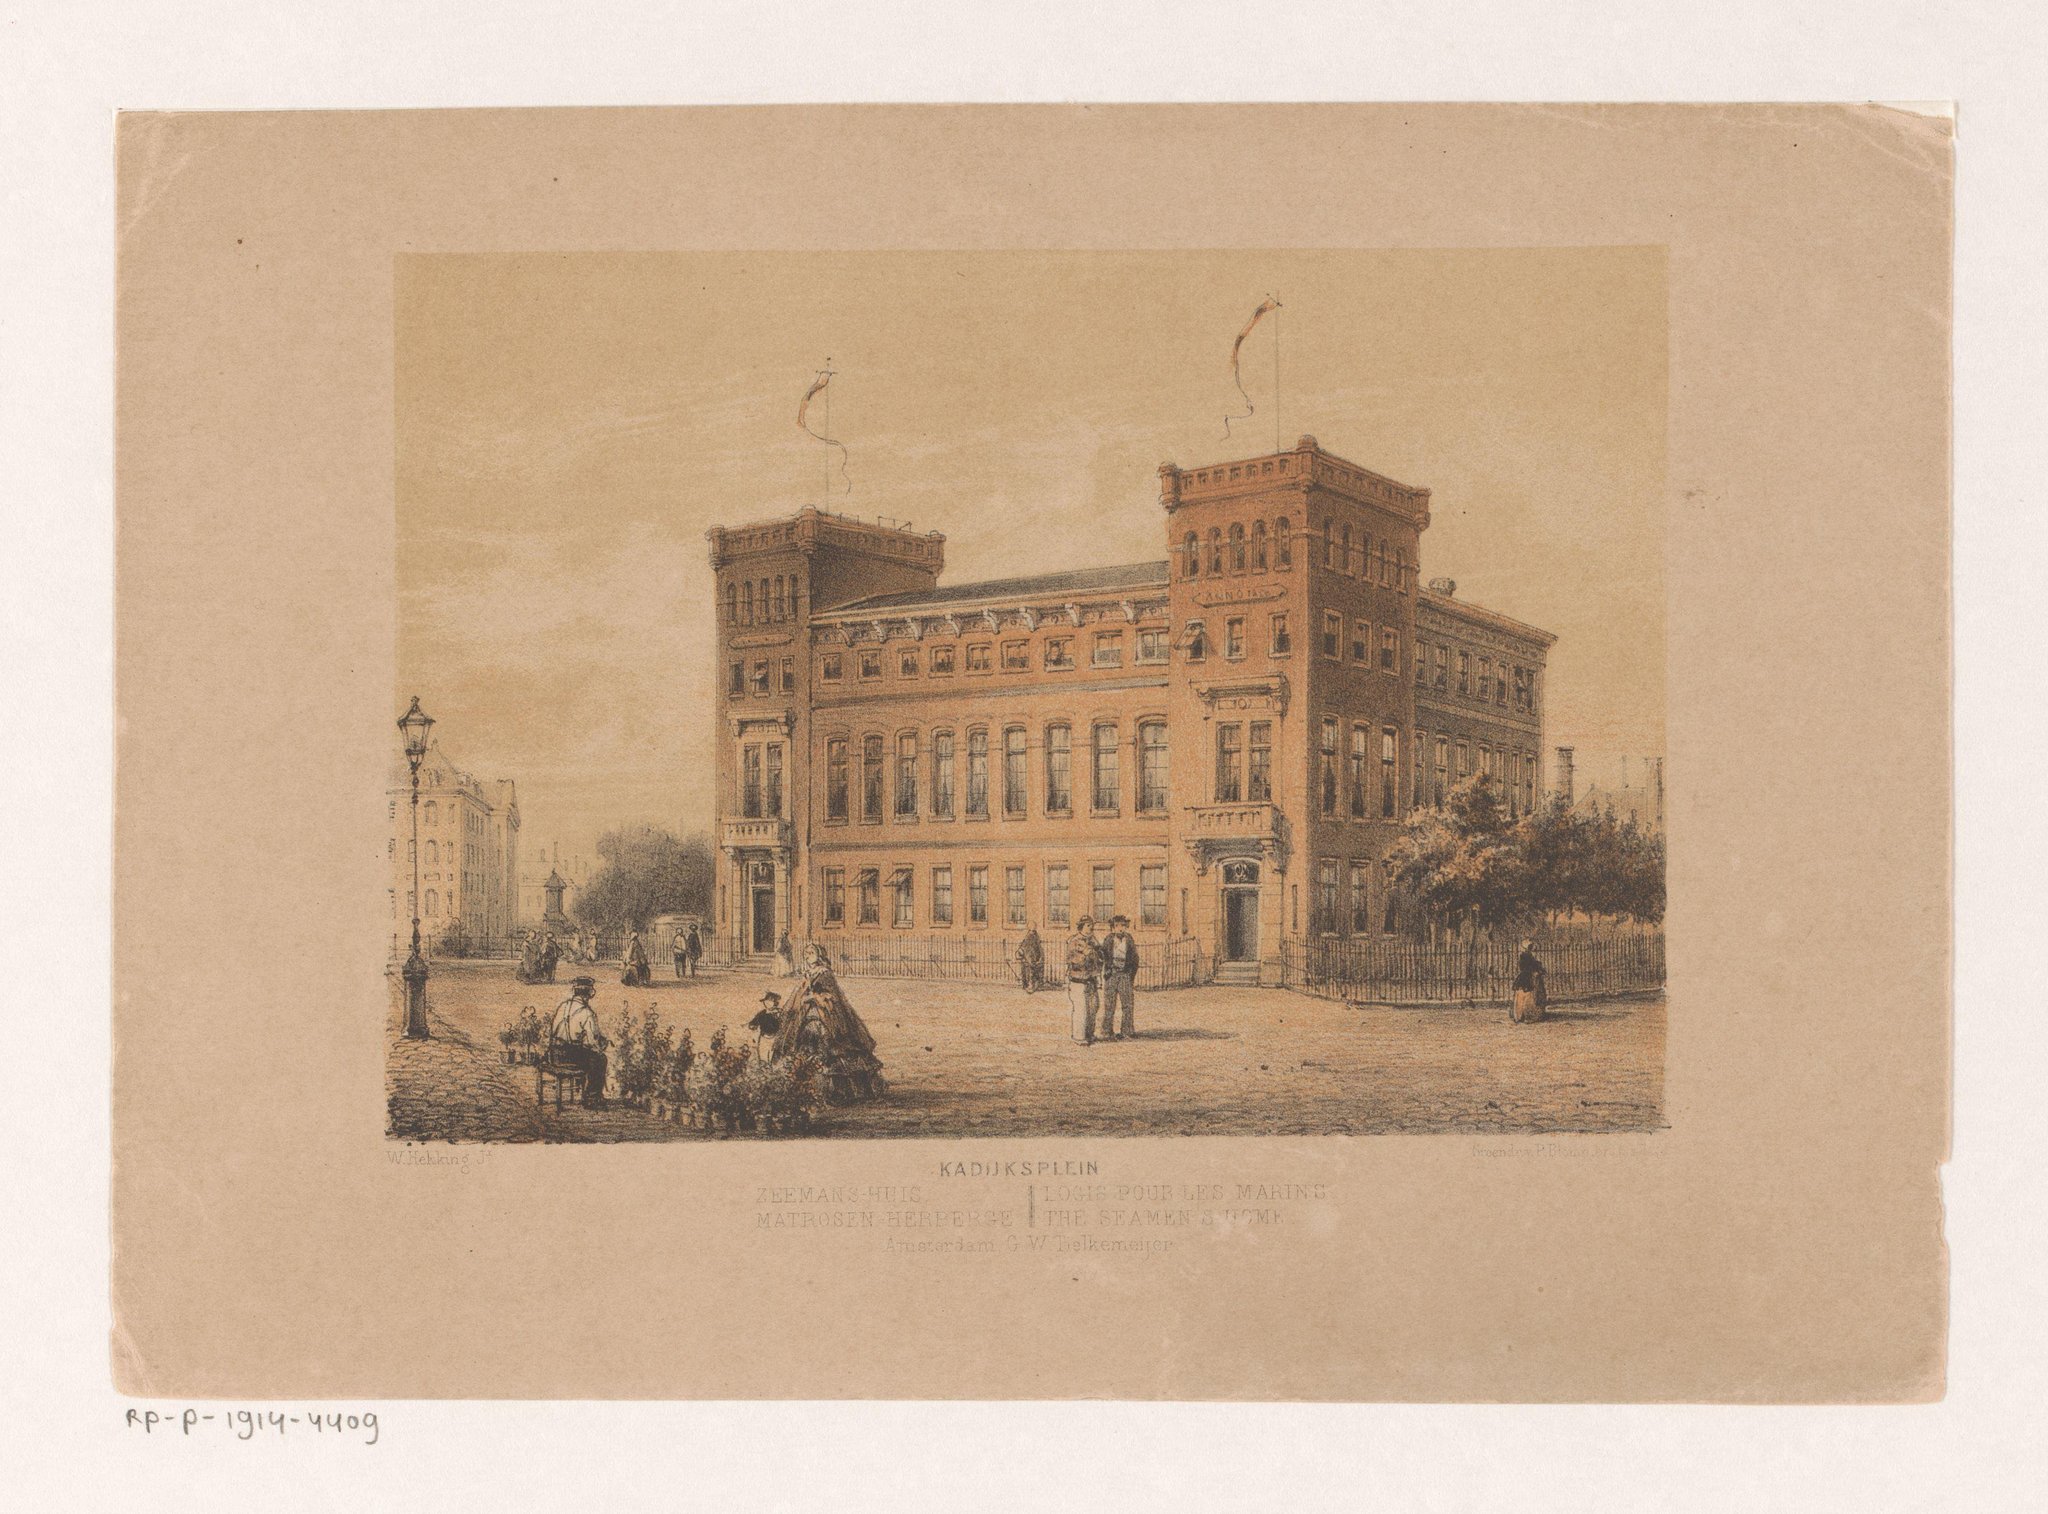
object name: print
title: Gezicht op het Zeemanshuis te Amsterdam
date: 1843-1887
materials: paper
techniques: tone lithography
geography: amsterdam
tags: garrison (+ naval force)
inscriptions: collector's mark: Lugt 2228